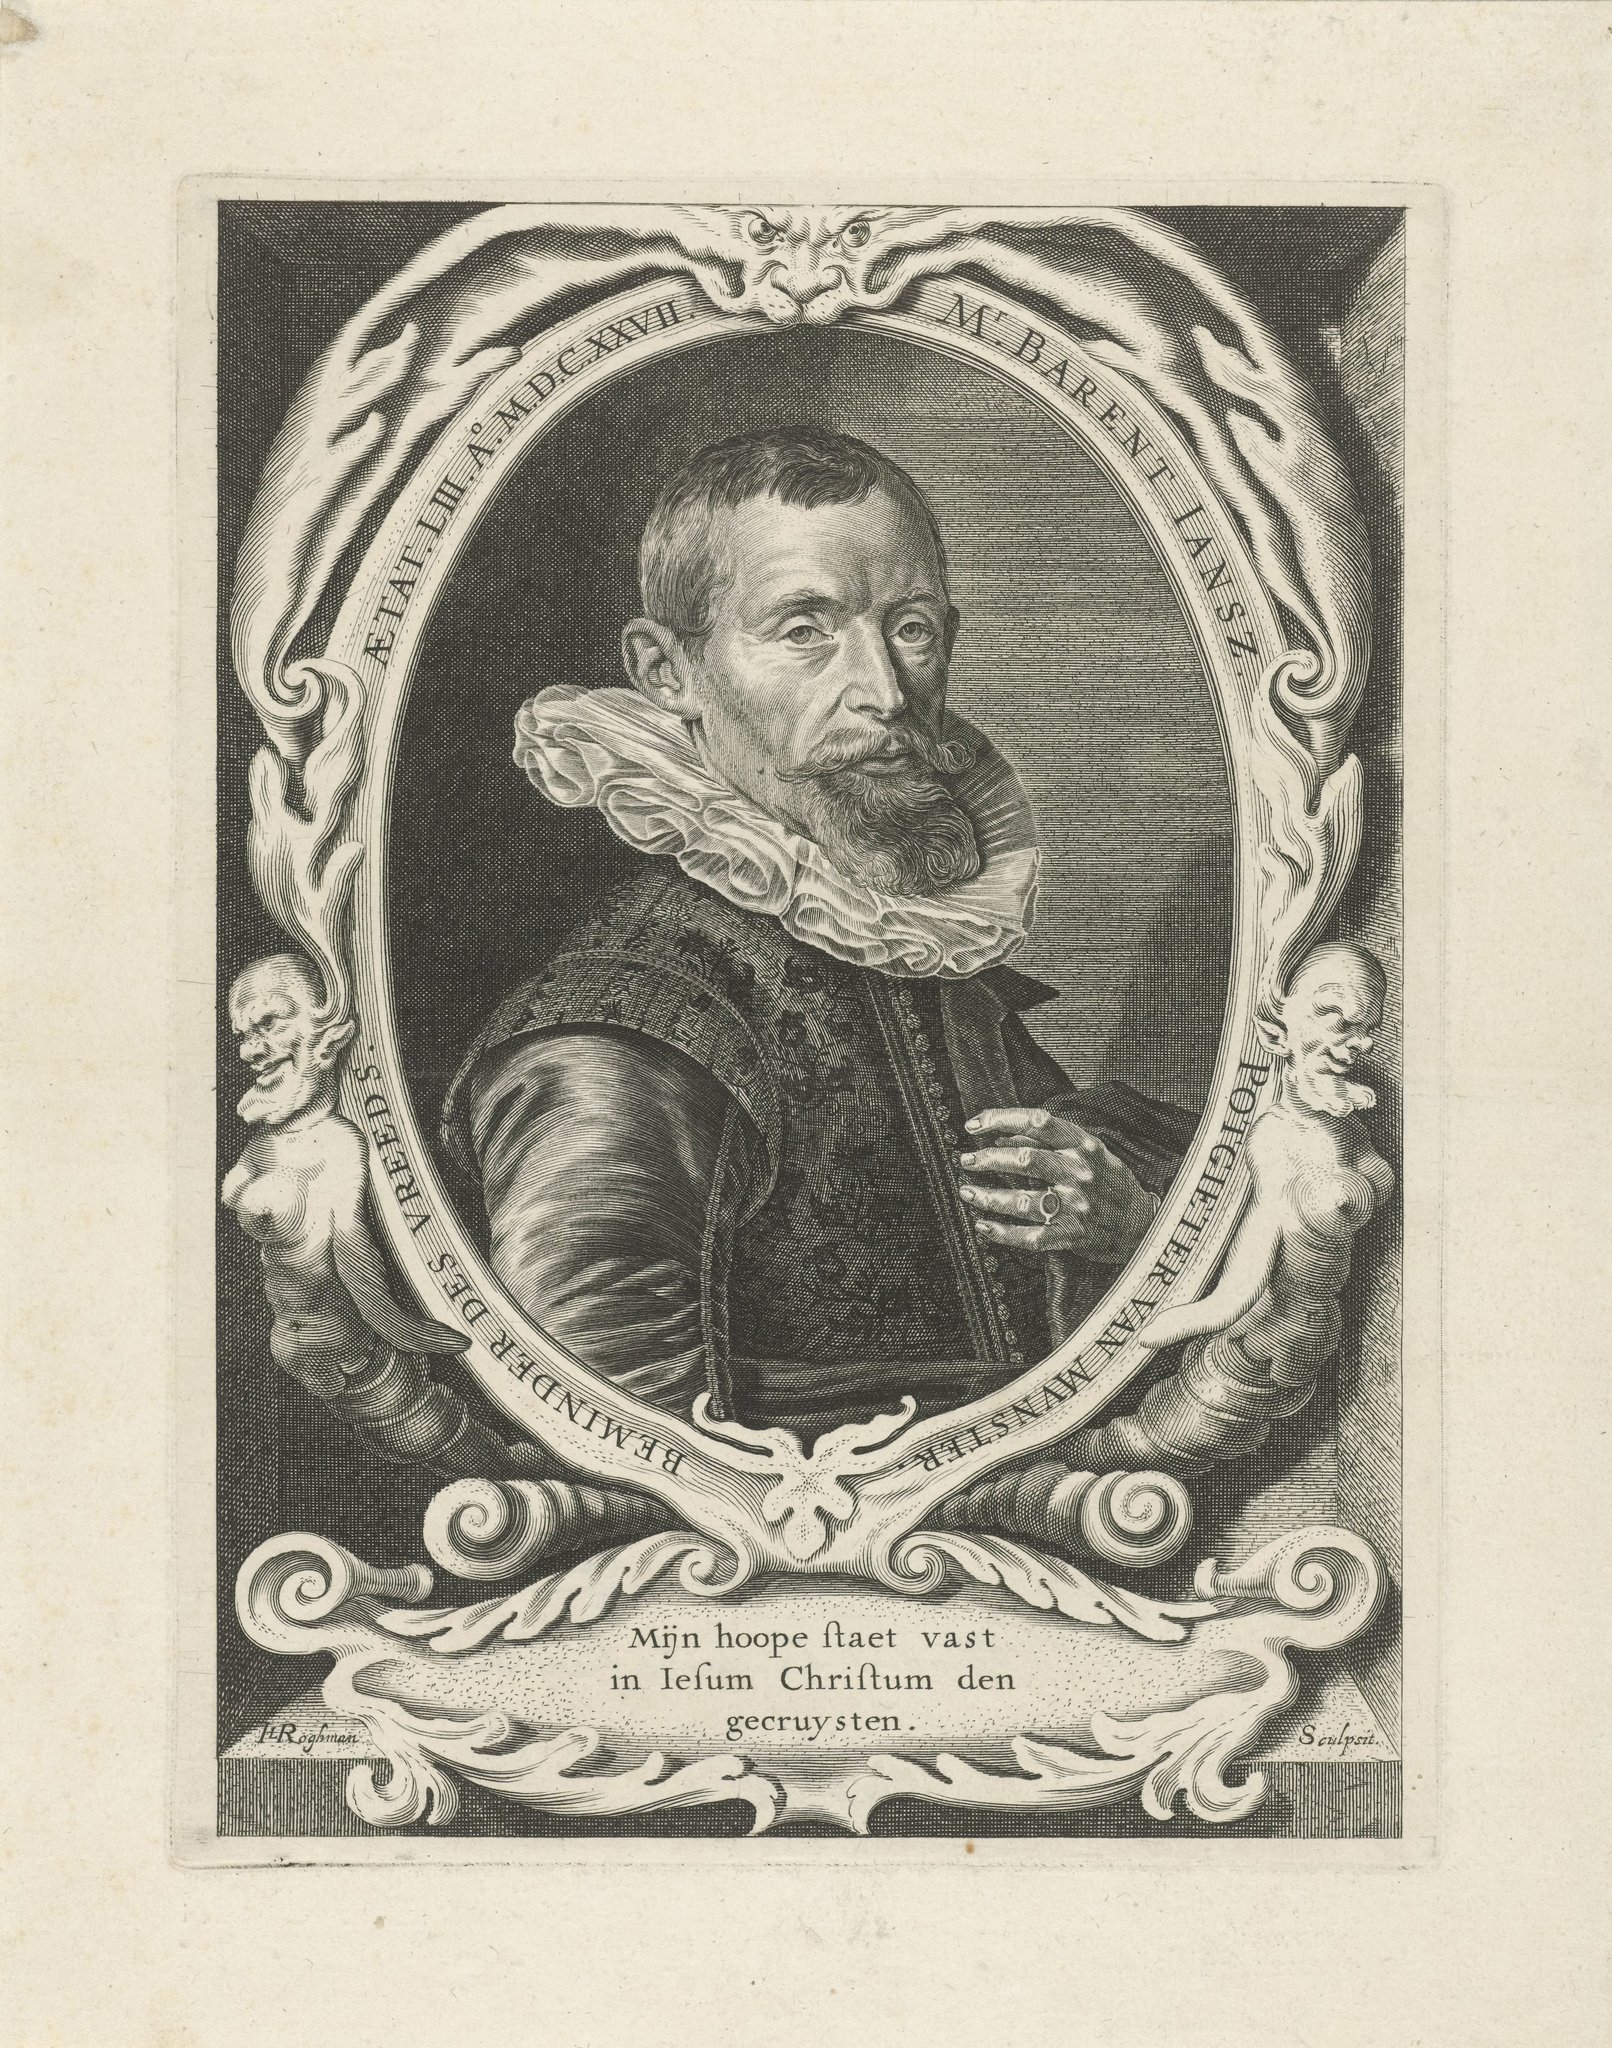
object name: print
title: Portret van Barent Jansz. Potgieter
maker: hendrick lambertsz. roghman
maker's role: print maker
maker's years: 1600-1647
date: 1627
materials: paper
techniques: engraving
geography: northern netherlands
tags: barent jansz. potgieter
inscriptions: collector's mark: Lugt 2228a, collector's mark: Lugt 2166, collector's mark: Lugt 2760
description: Portret van de scheepschirurgijn Barent Jansz. Potgieter, op 53-jarige leeftijd. Het portret is gevat in een kwablijst. Onder het portret een cartouche met zijn zinspreuk: 'mijn hoop staat vast in Christus den gekruisten'.